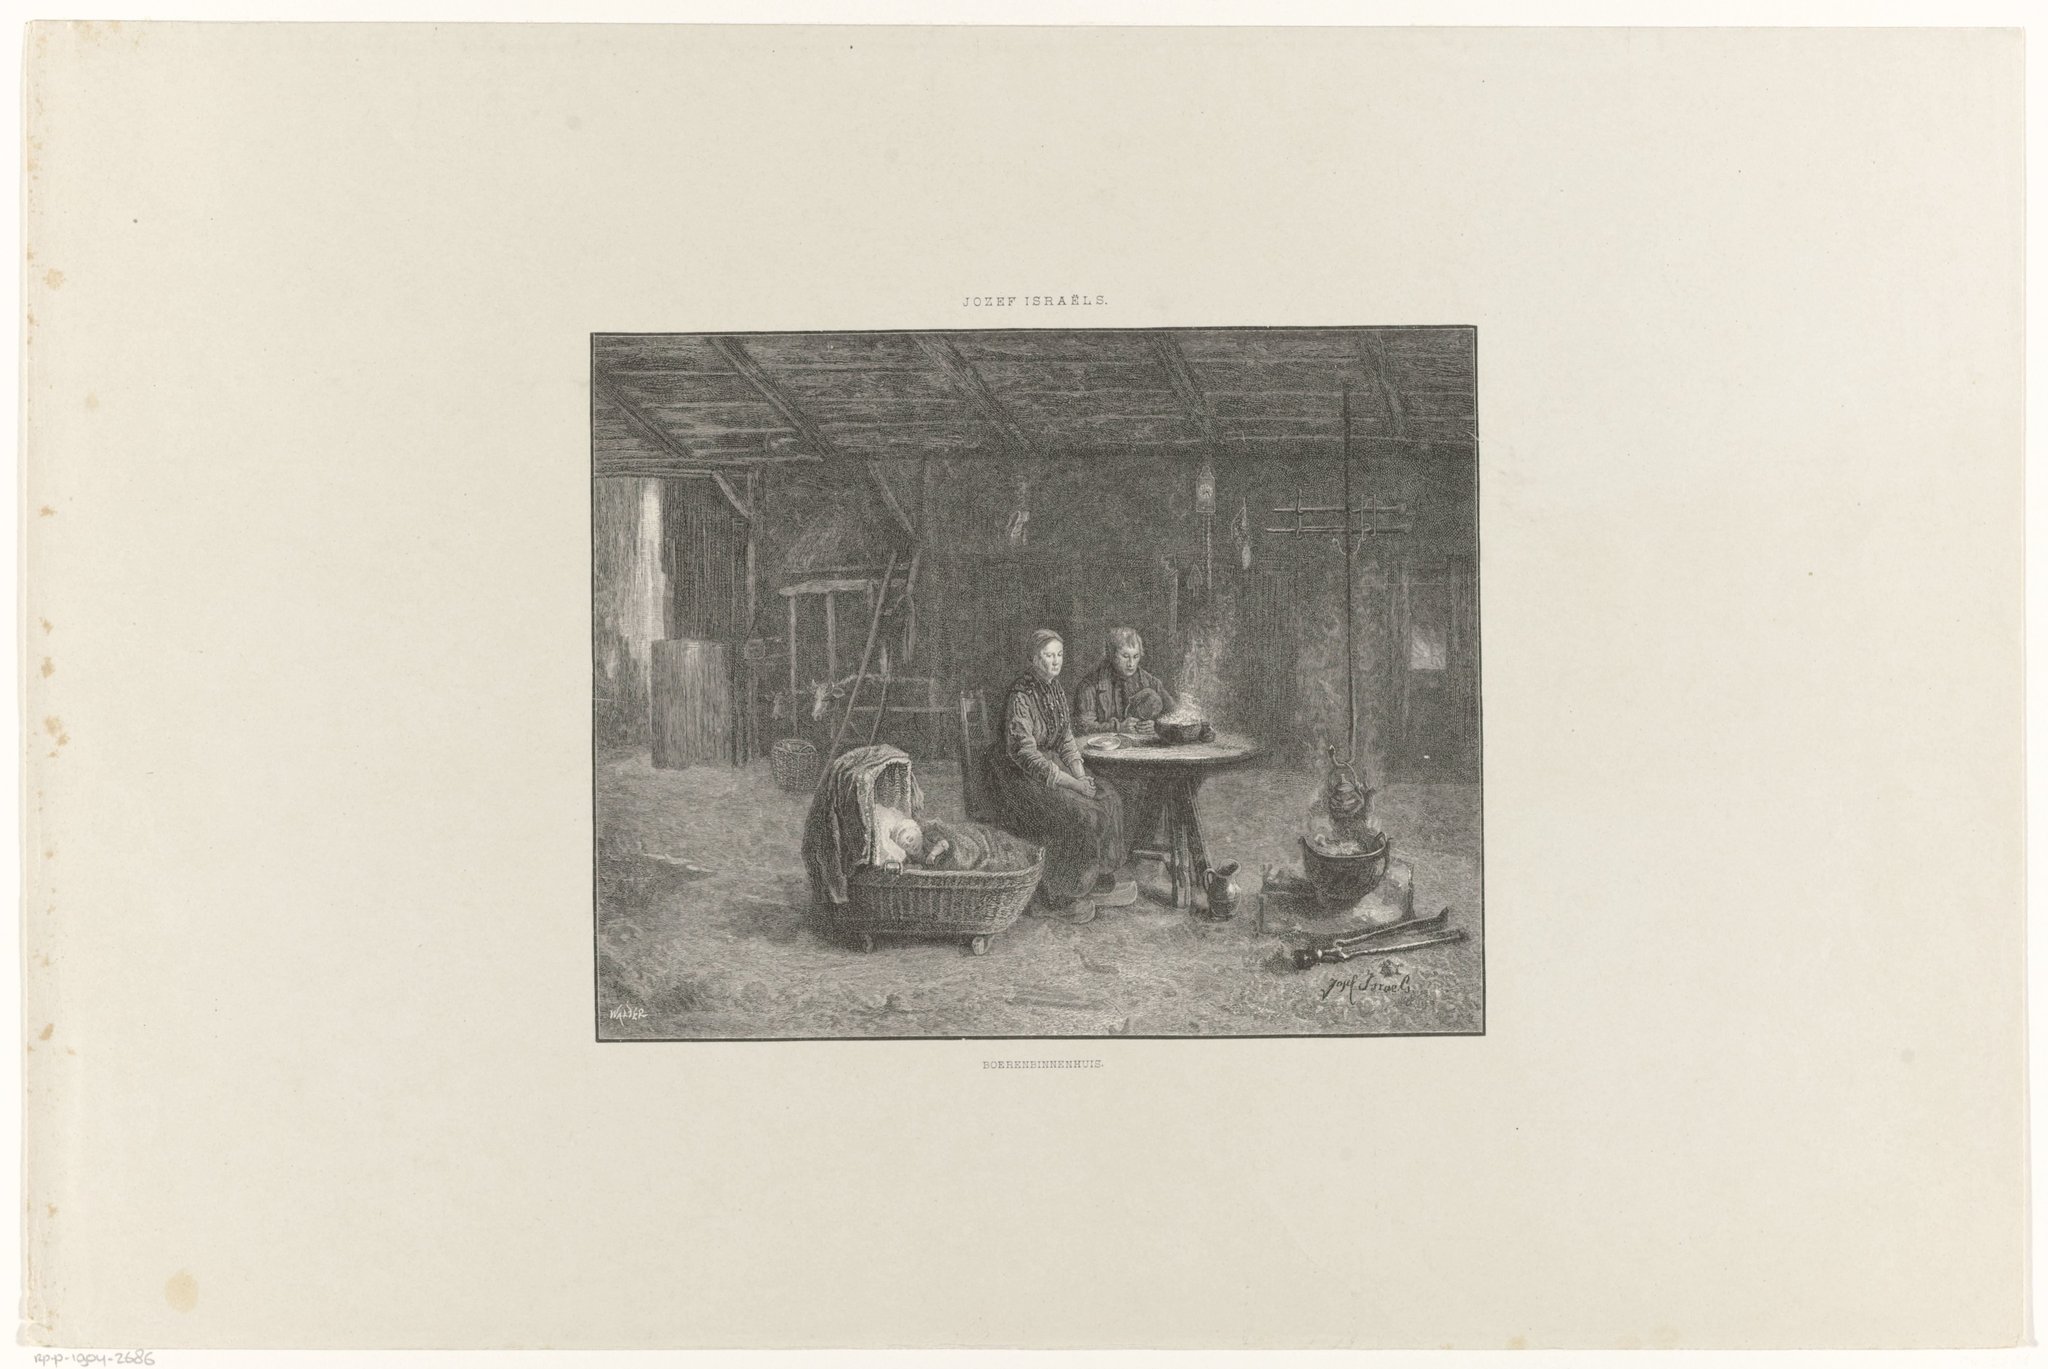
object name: print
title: Boerenbinnenhuis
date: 1849-1895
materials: paper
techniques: engraving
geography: netherlands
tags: farmers, family life at home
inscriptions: collector's mark: Lugt 2228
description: Interieur met een man en een vrouw aan een tafel. Naast hen staat een wieg met daarin een slapend kind. Rechts hangt een ketel boven het vuur.